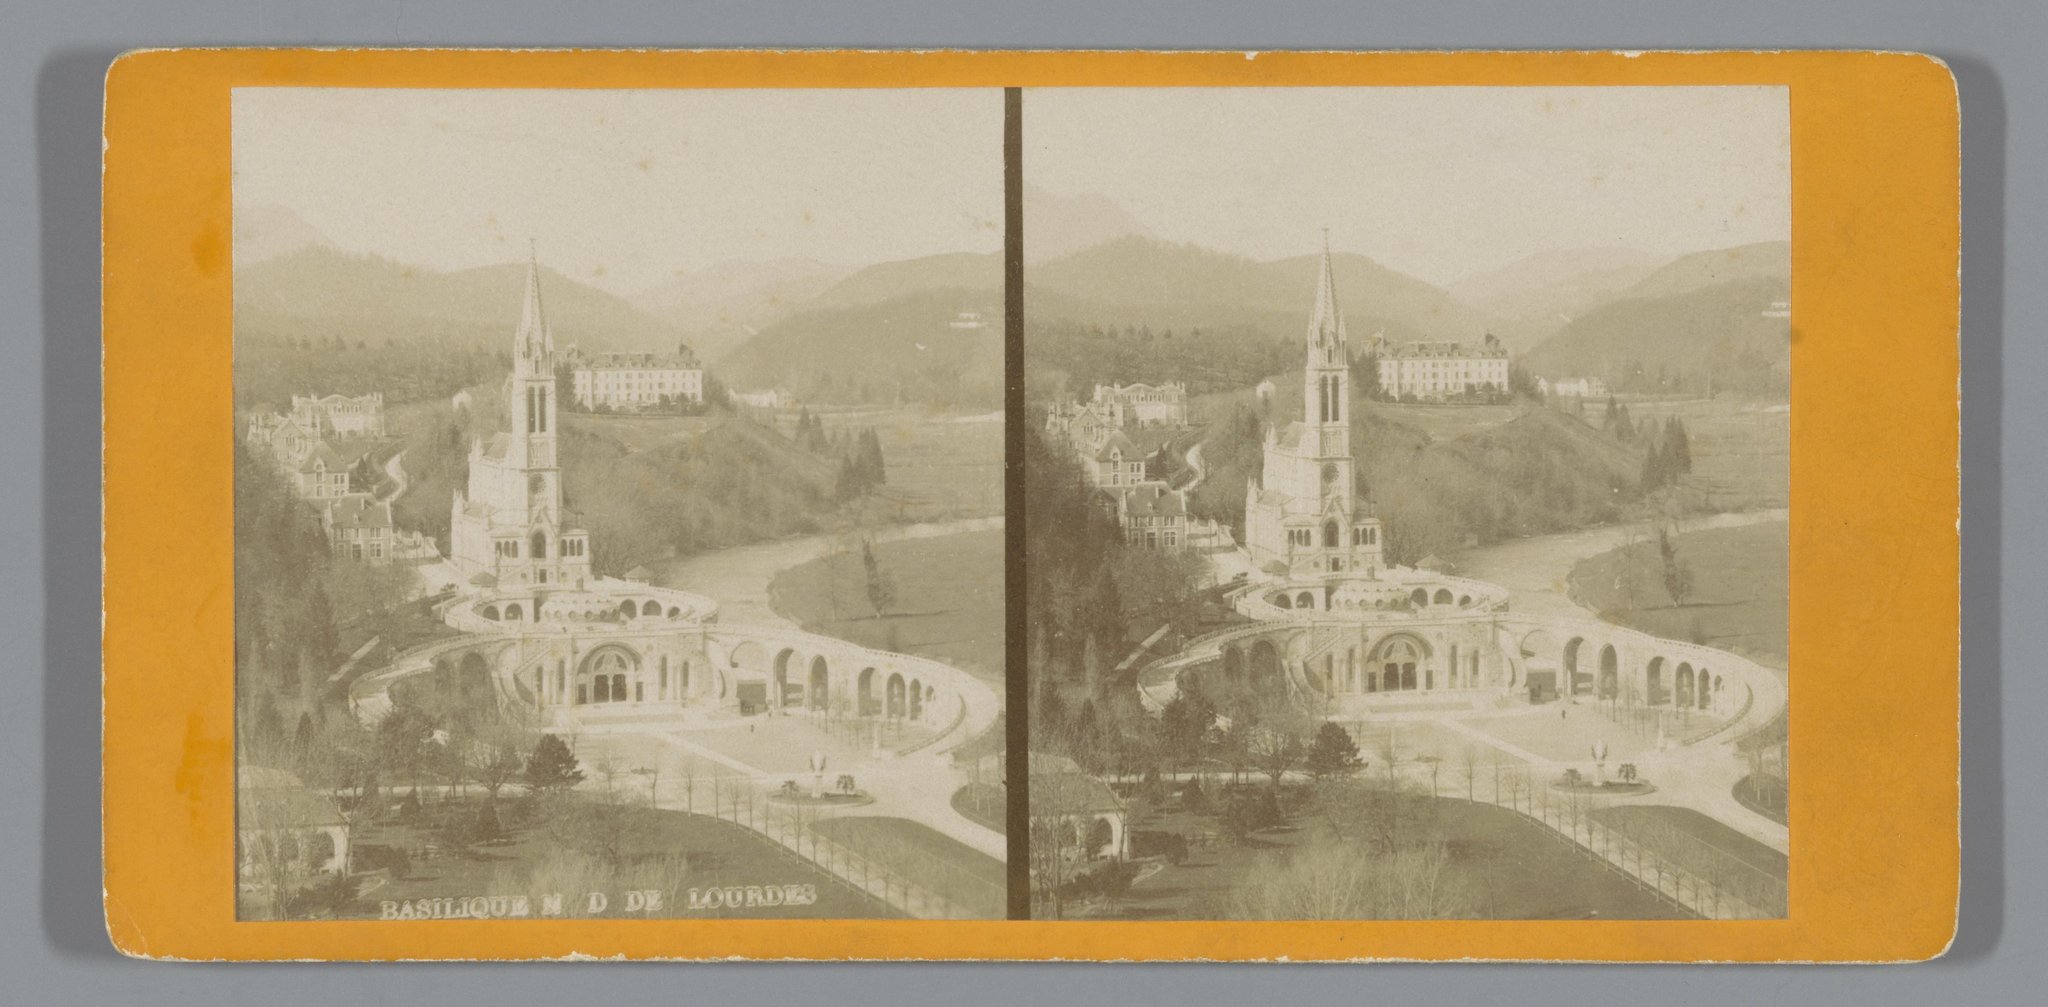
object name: stereograph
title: Gezicht op de Basiliek van de Onbevlekte Ontvangenis te Lourdes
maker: p. viron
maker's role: fotograaf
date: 1860-1880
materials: cardboard, photographic support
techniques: albumen print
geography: lourdes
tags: church (exterior), façade (of house or building)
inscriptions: inscription: ‘P. Viron photographe-éditeur 52, Rue de la Grotte <en face l'hôtel de la grotte> Lourdes déposé’